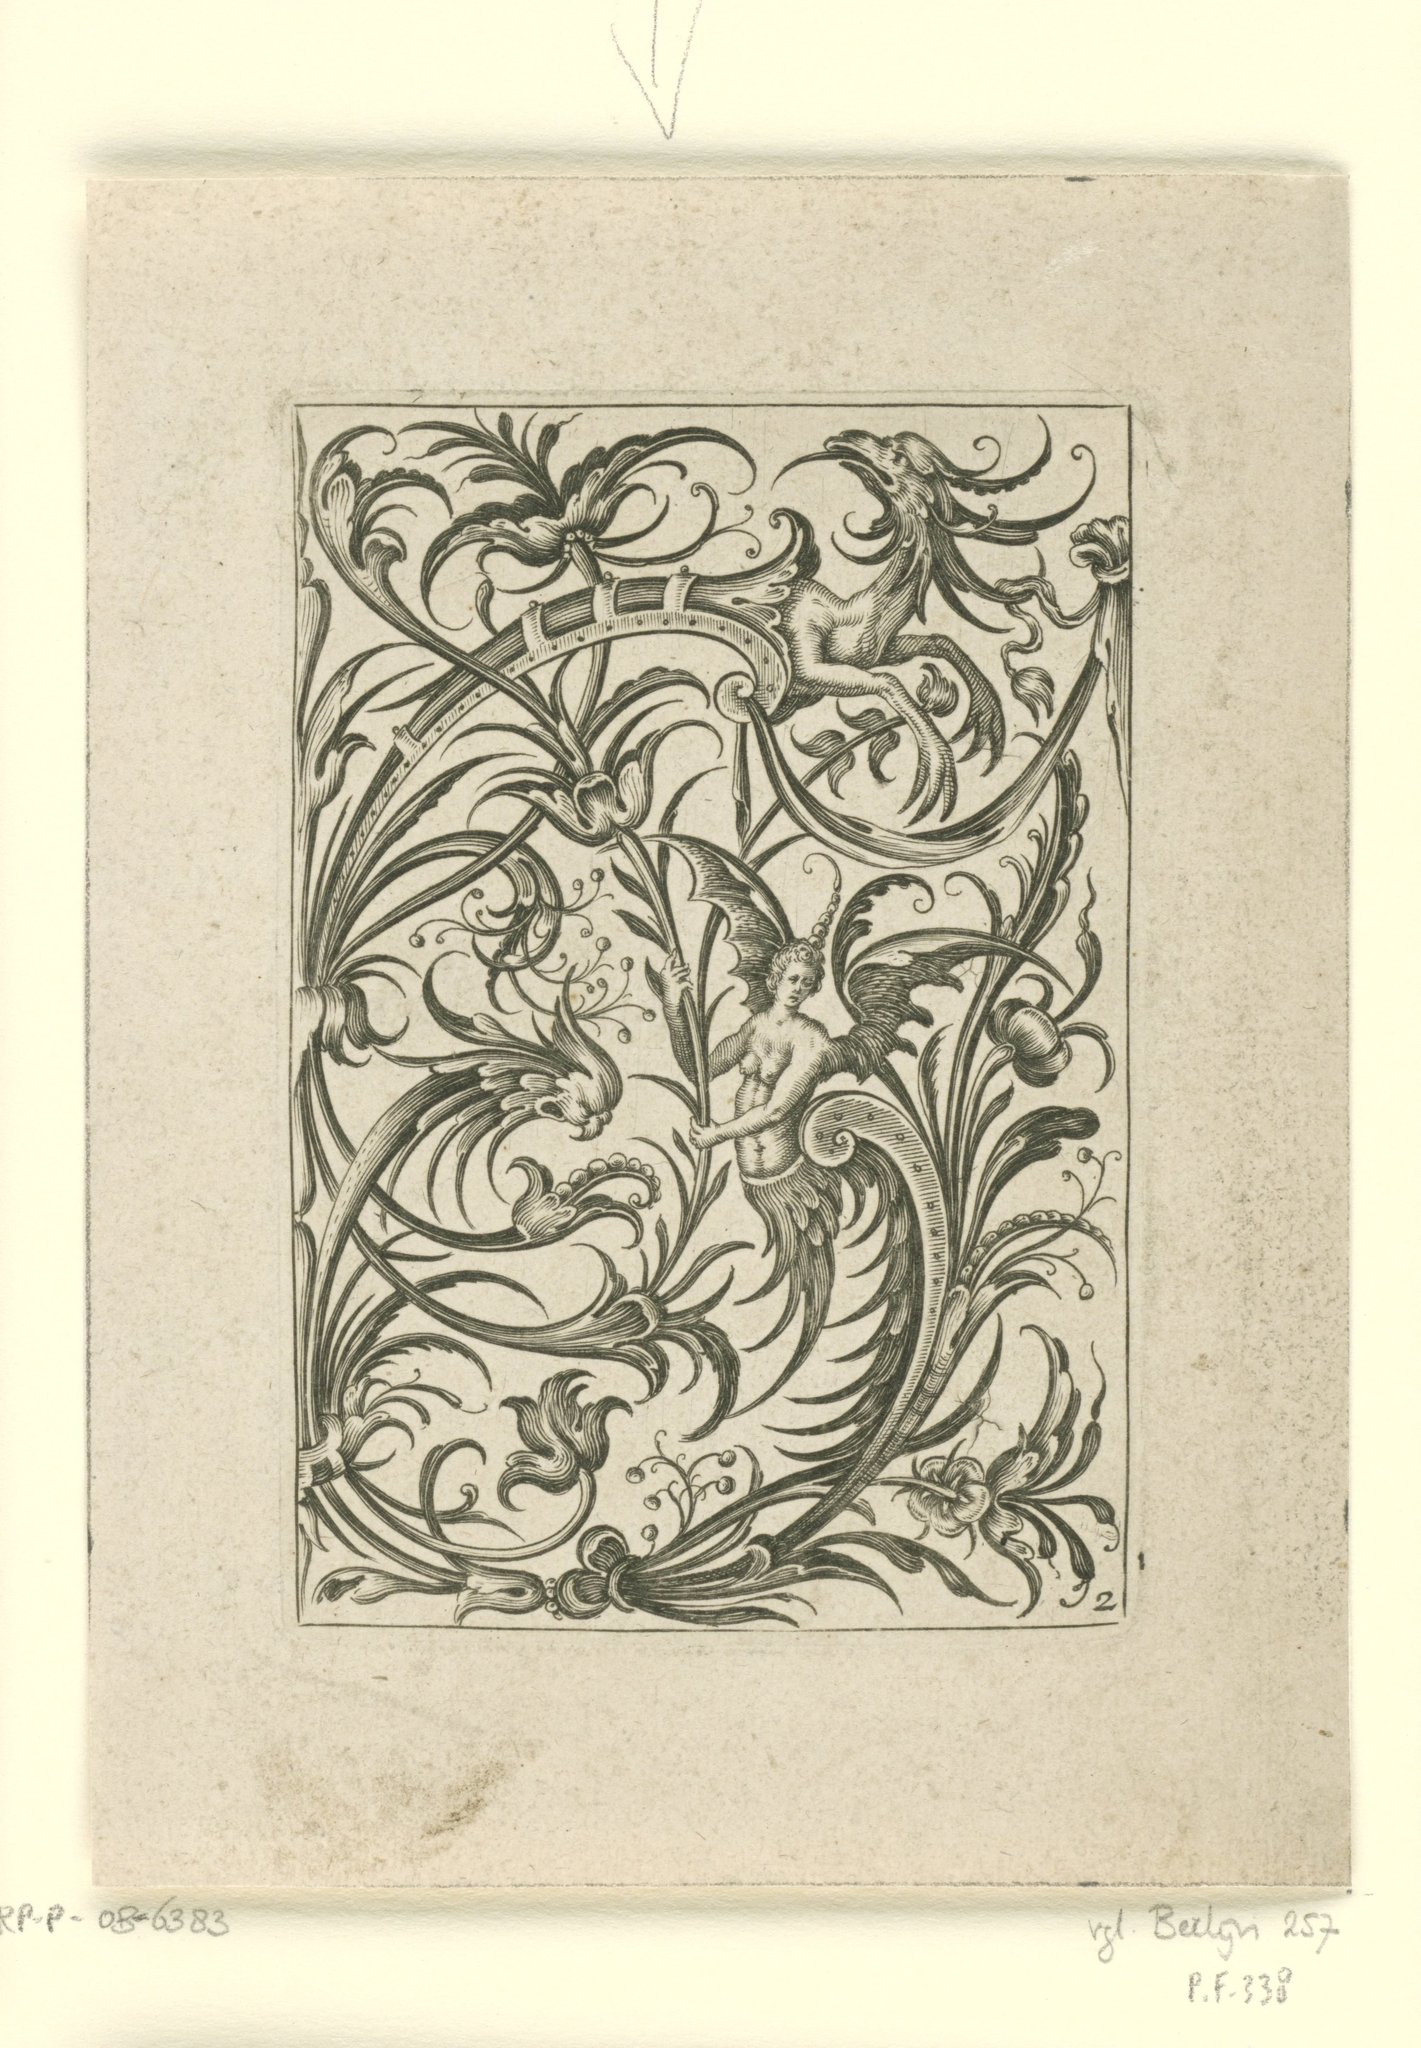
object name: ornament print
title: Paneel met bladranken die uitlopen in een vrouwelijk torso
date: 1684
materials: paper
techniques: engraving, etching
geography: amsterdam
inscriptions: number: ‘2’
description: Blad uit serie met tegenzijdige kopieën naar de serie De Grotesco van Nicasius Rousseel.